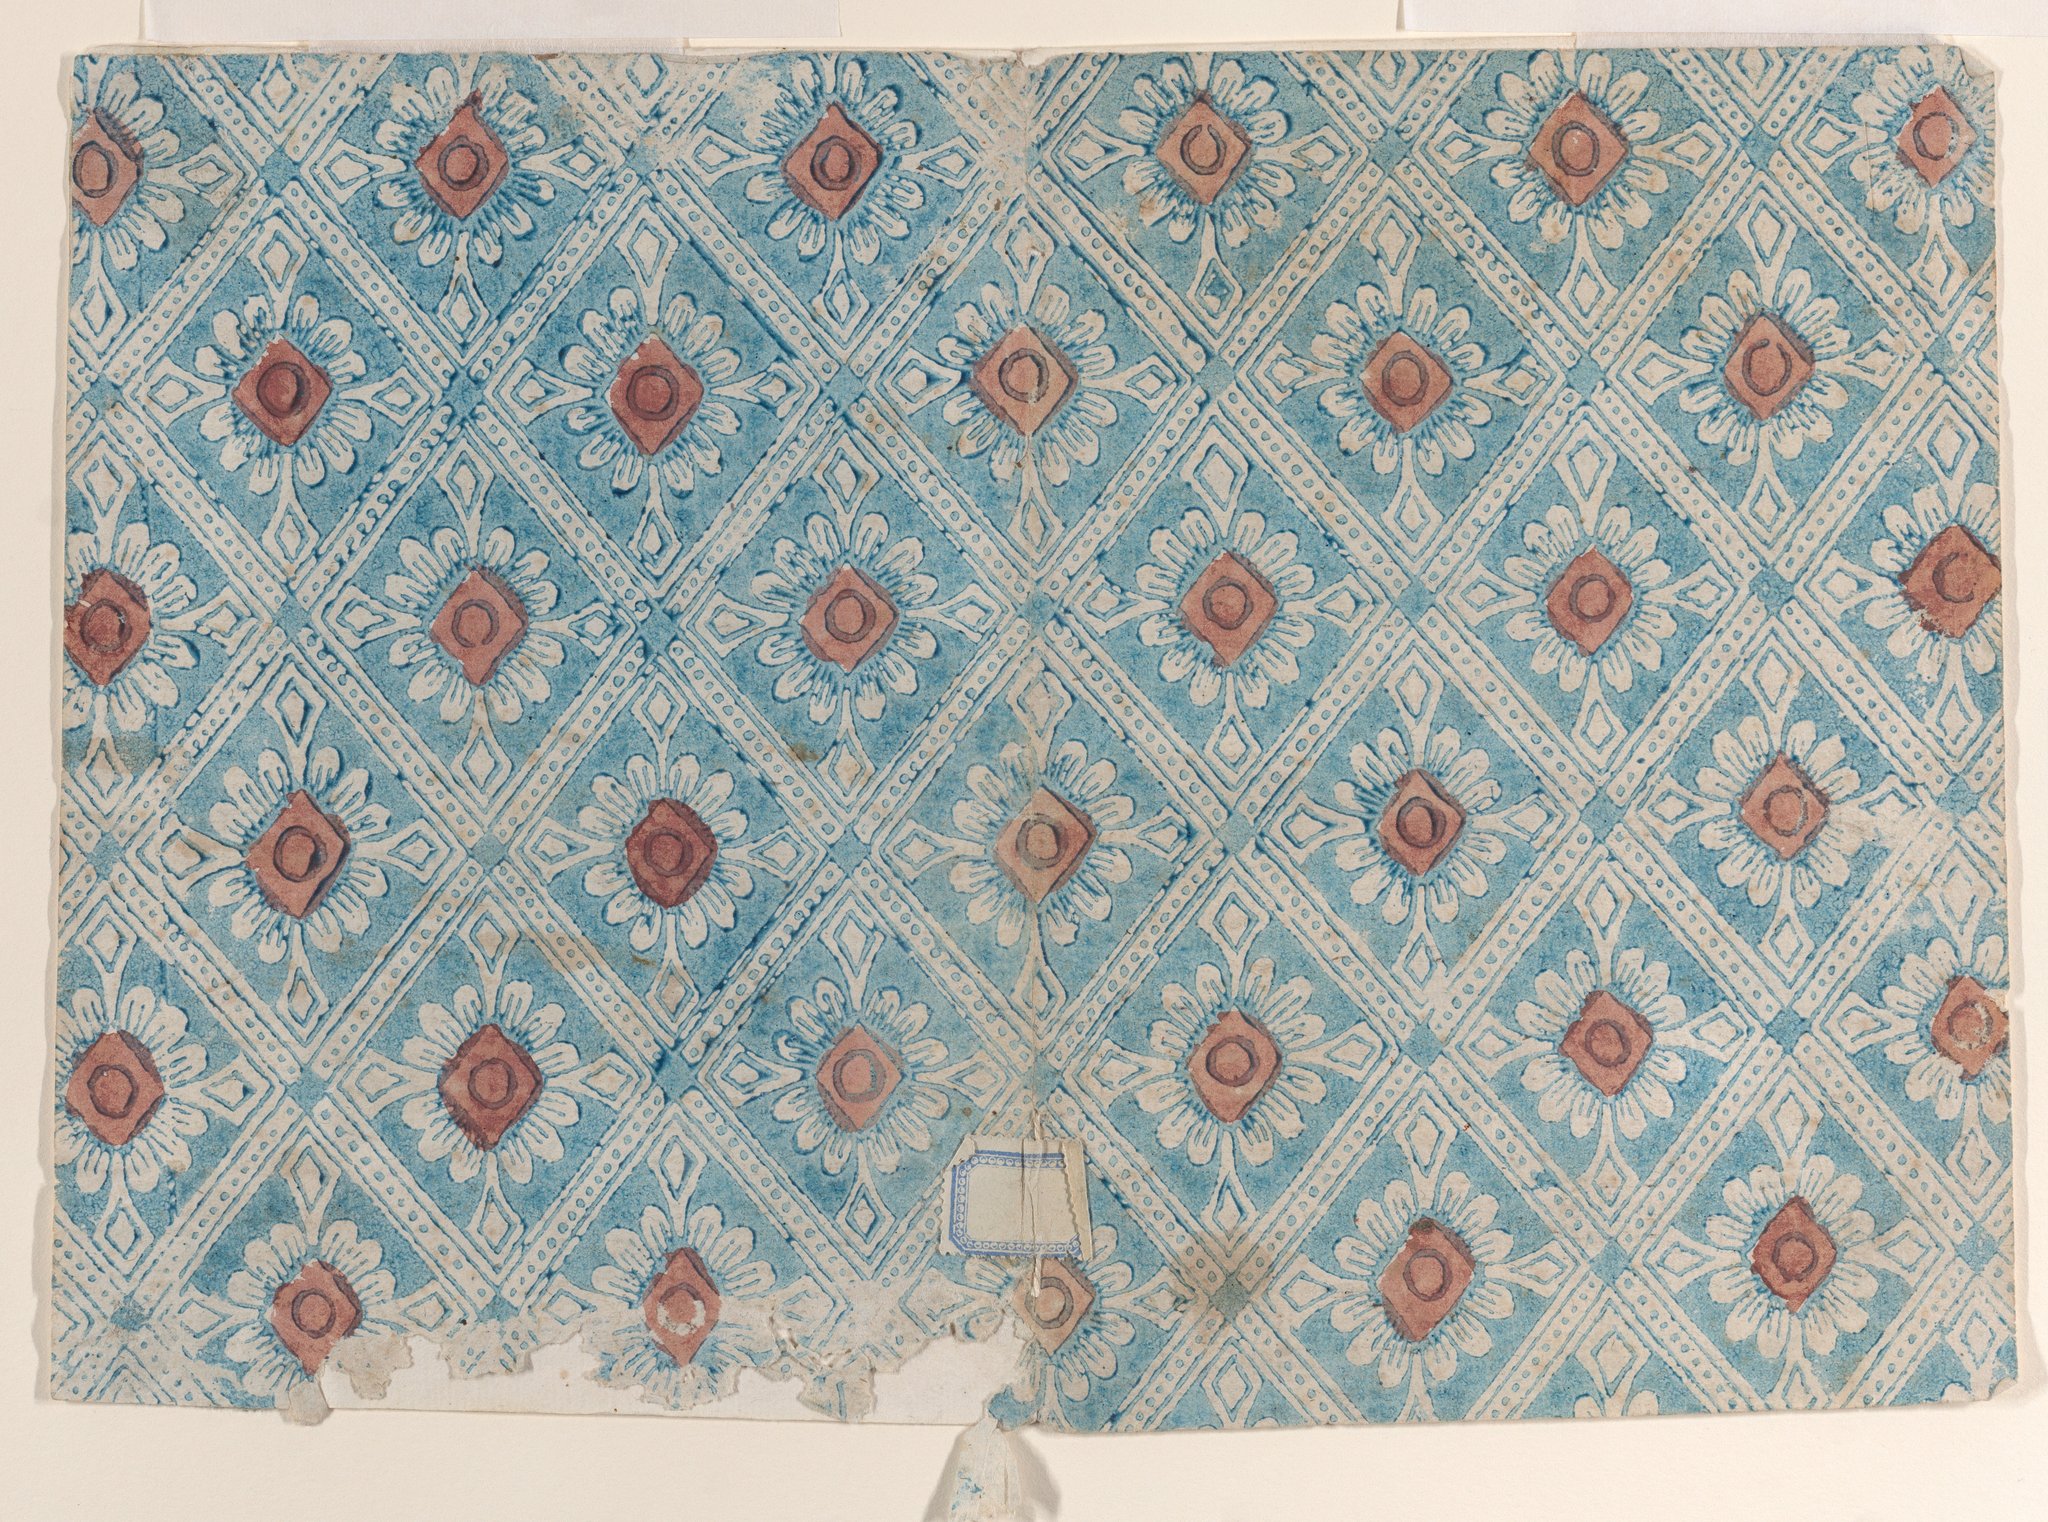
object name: print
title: Book cover for Ferdinando Giorgi's Estratto, Florence, 1786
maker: Anonymous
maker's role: artist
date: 1786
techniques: relief print